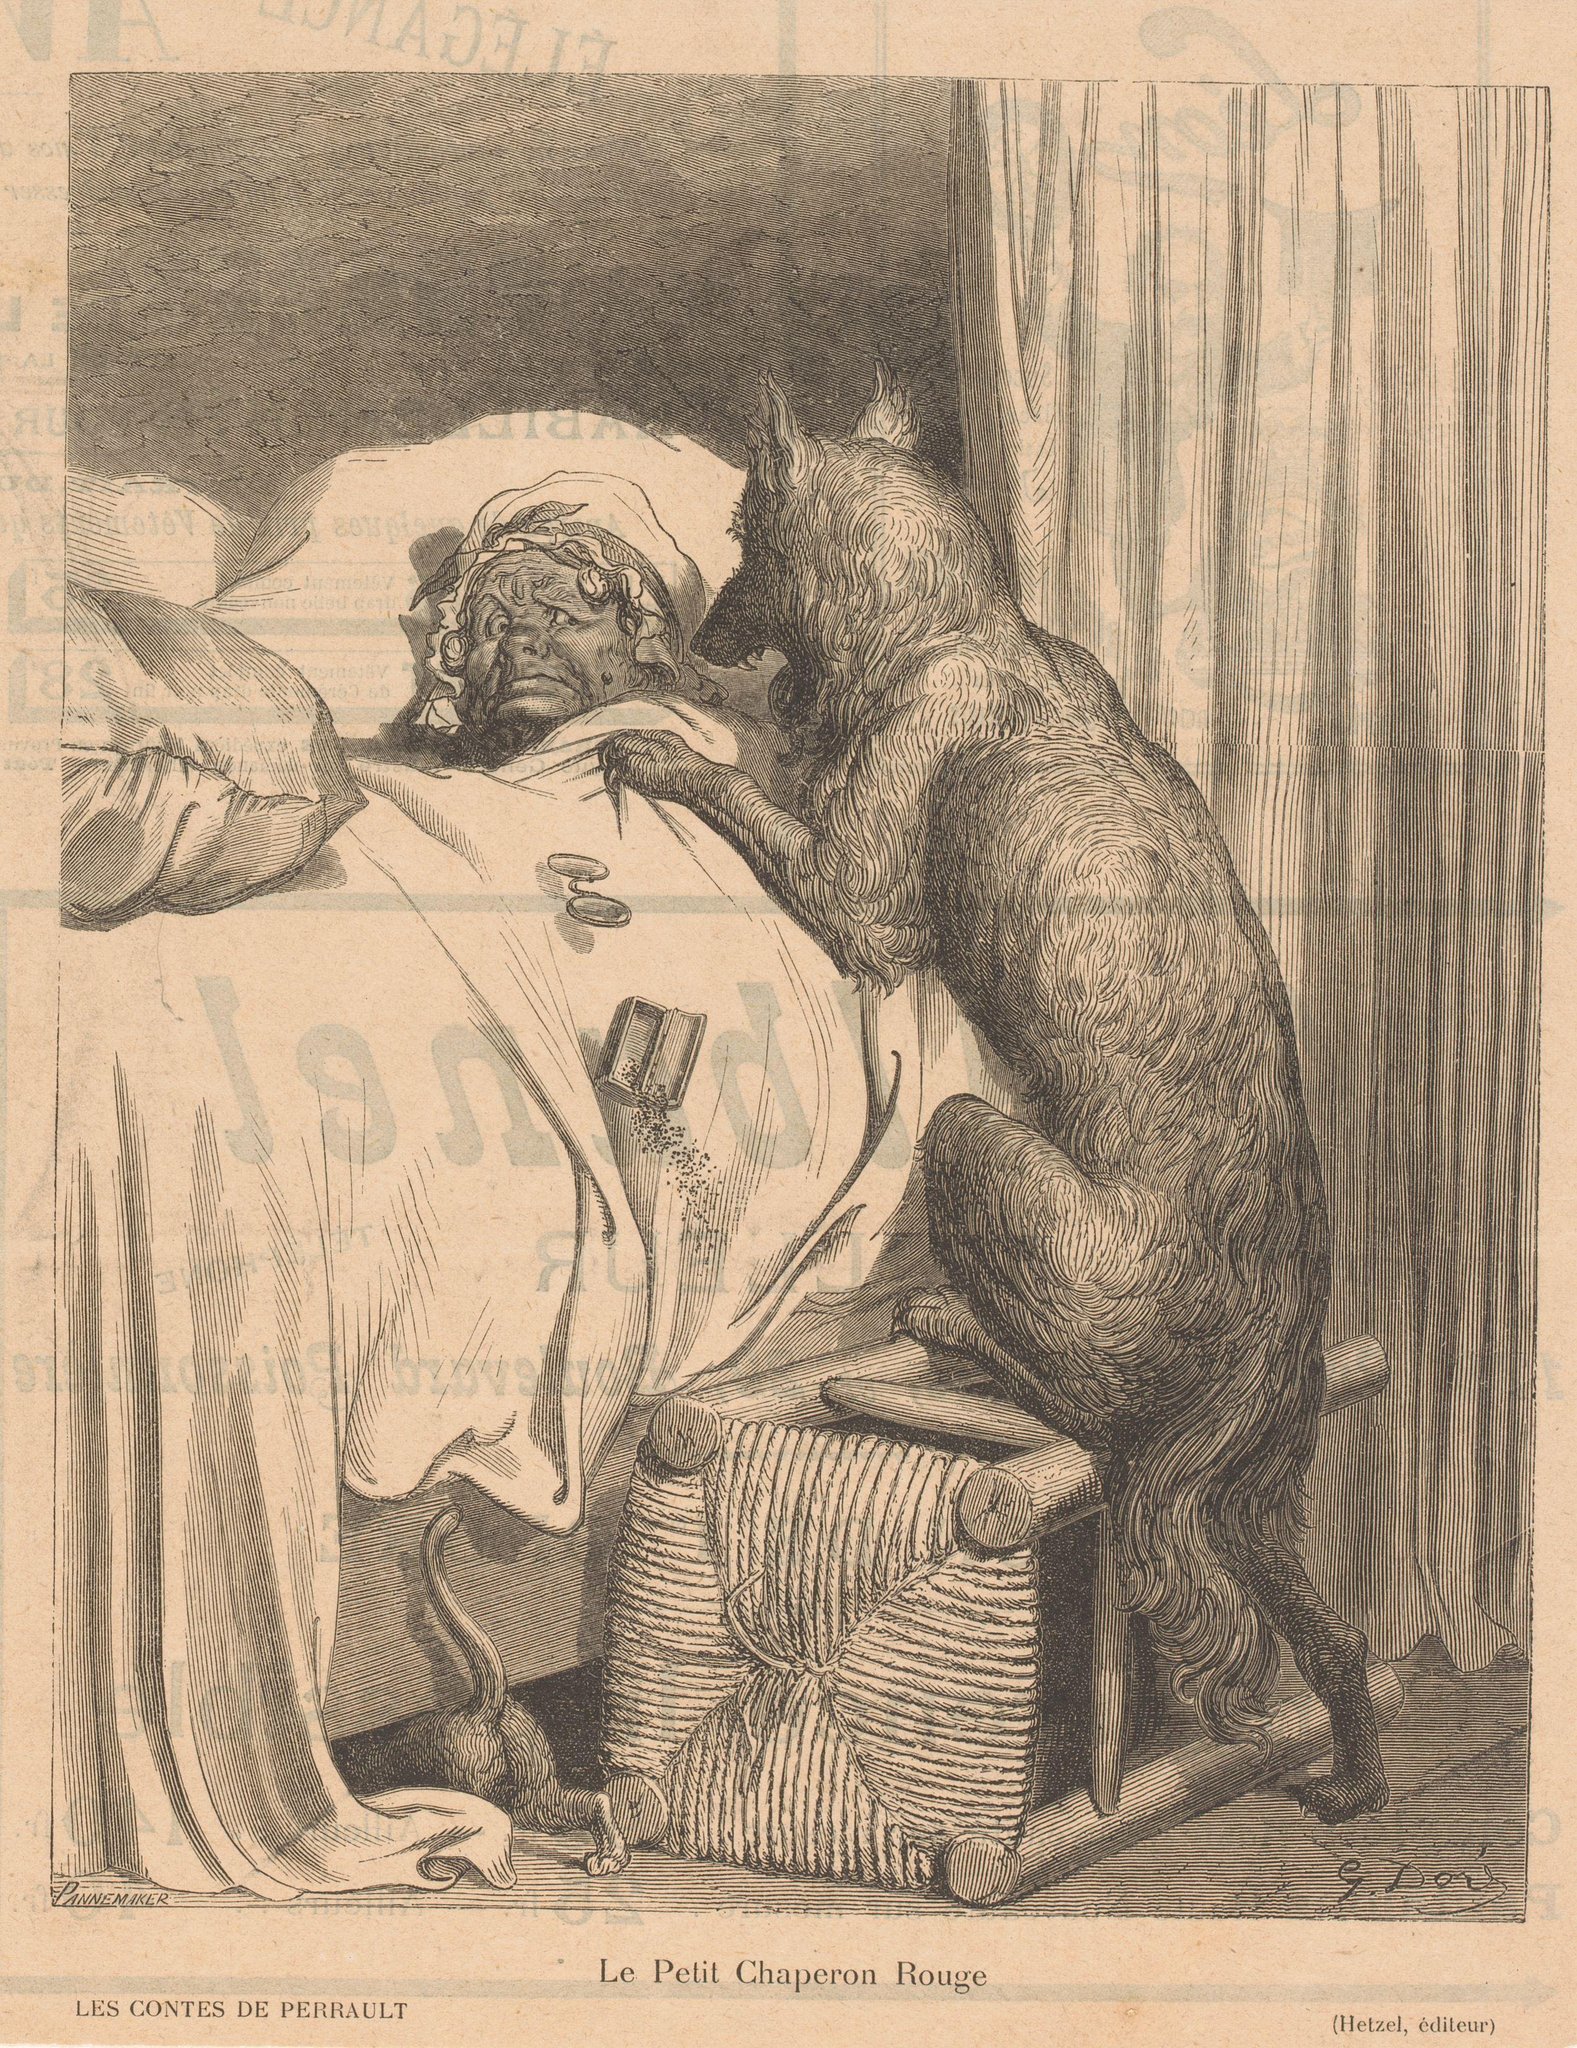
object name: print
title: Le Petit Chaperon Rouge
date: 1867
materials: paper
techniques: letterpress printing, engraving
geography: paris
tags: tales and fairy tales: little red riding-hood, beasts of prey, predatory animals: wolf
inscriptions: collector's mark: Lugt 2228, inscription: ‘Les contes de Perrault’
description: Prent gedrukt in een krant of tijdschrift met op verso diverse advertenties. Prent gebruikt in: Perrault, Charles. Les contes de Perrault. Parijs: J. Hetzel, 1867.